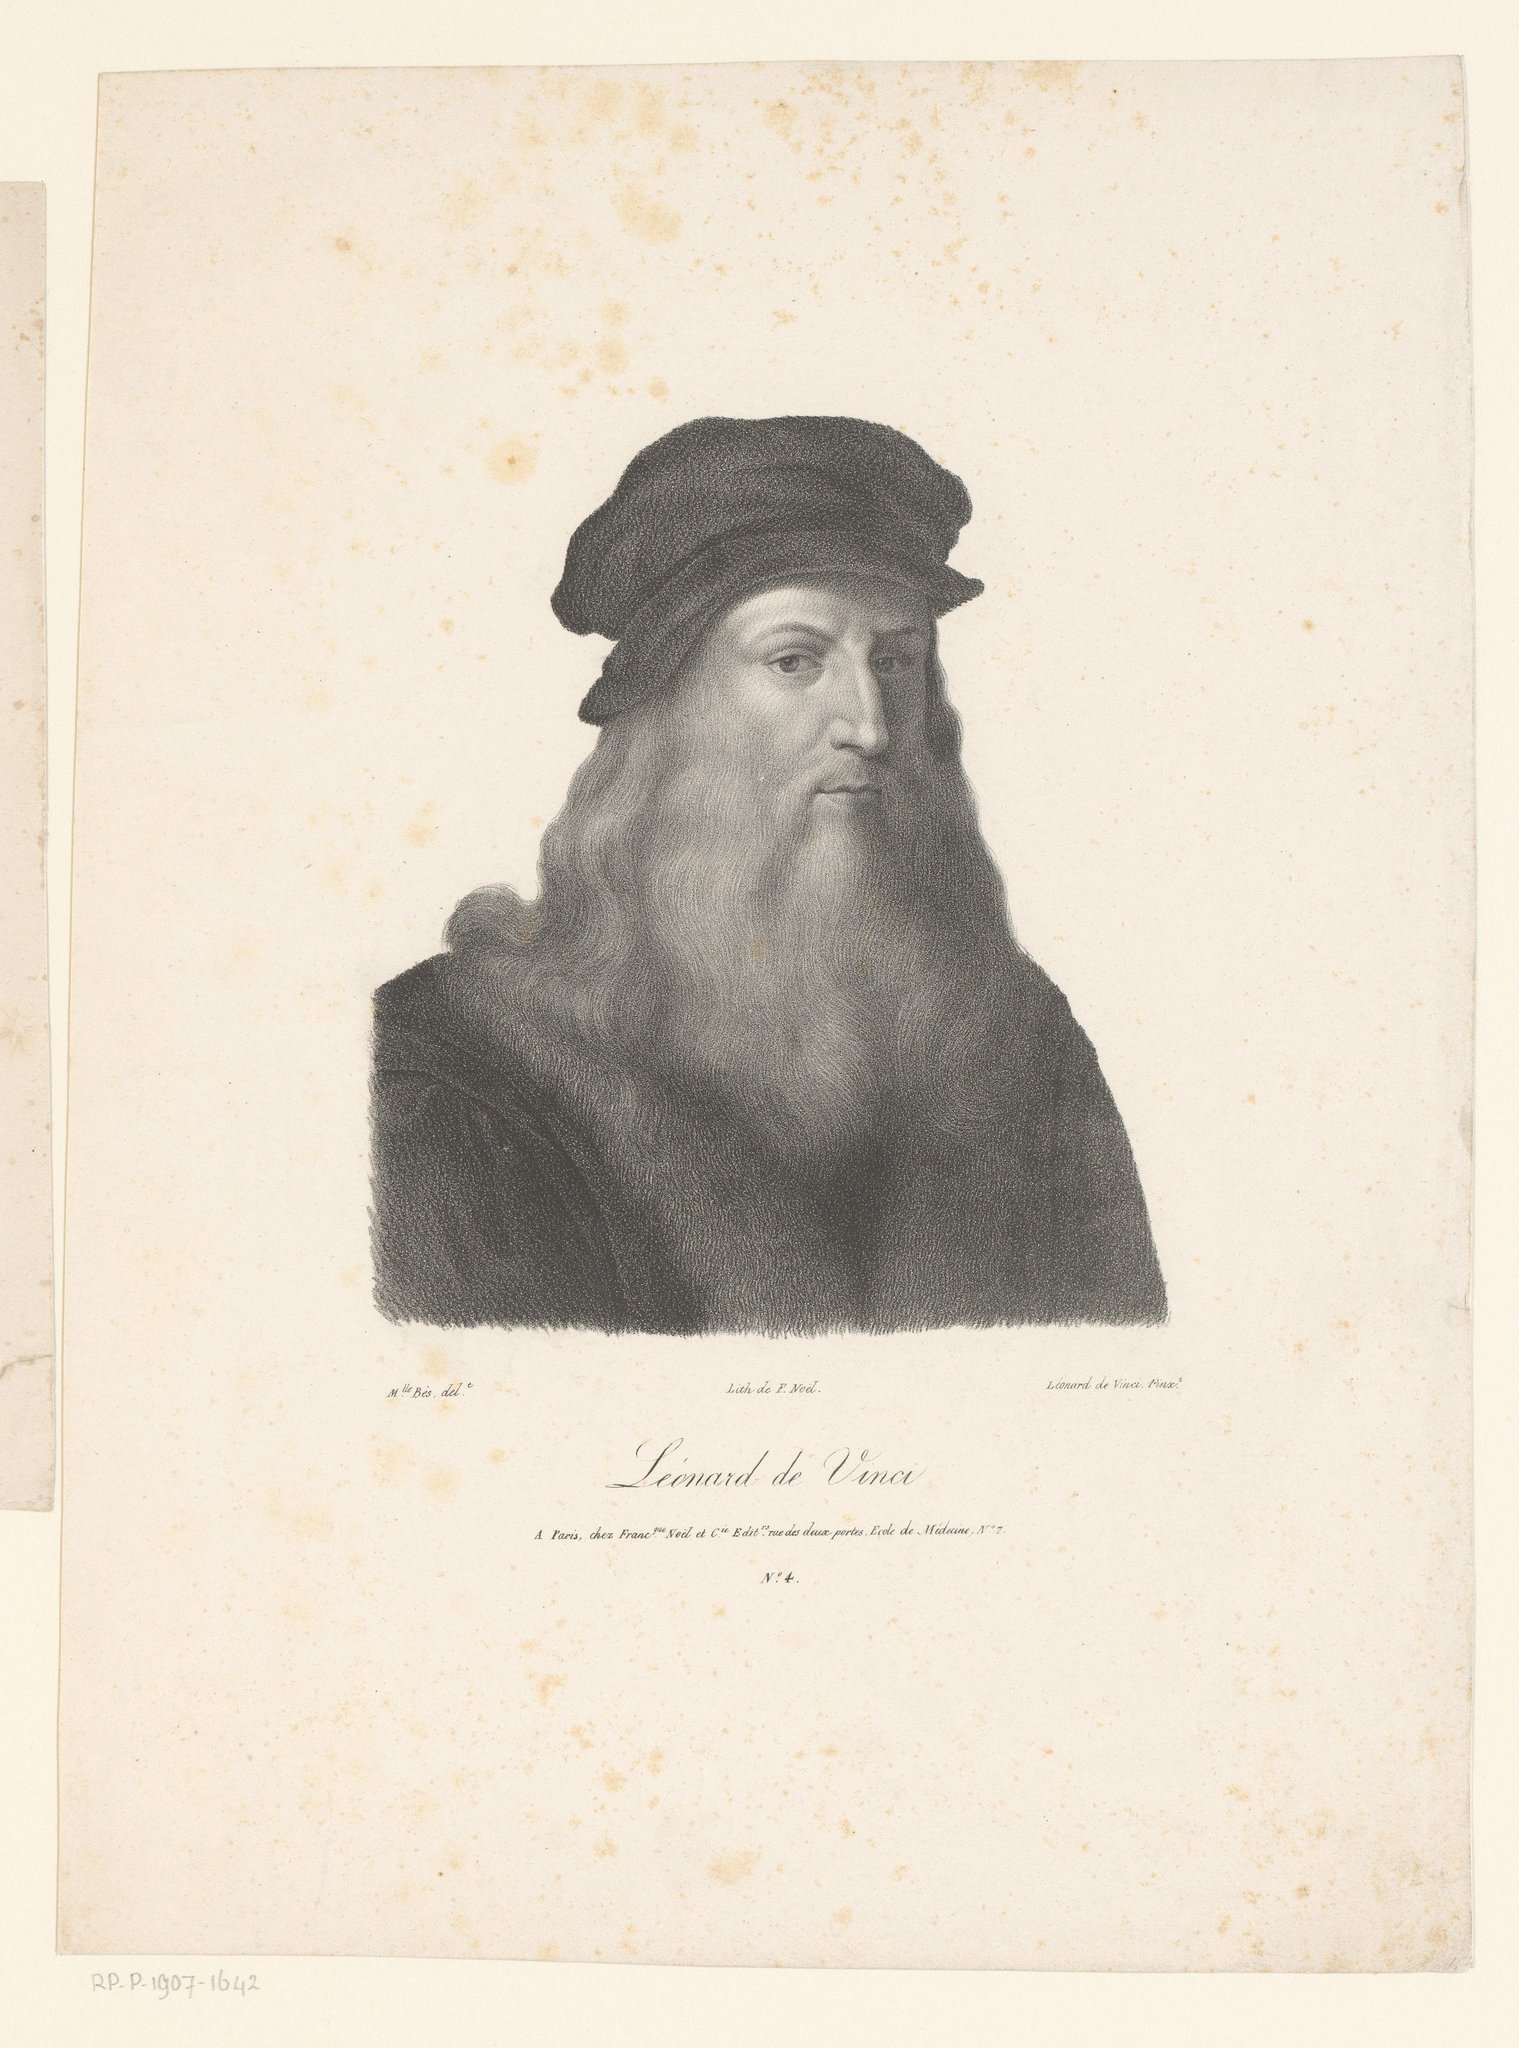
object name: print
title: Léonard de Vinci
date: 1824-1827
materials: paper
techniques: lithograph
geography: paris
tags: leonardo da vinci, historical persons, portrait, self-portrait of painter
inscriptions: collector's mark: Lugt 2228